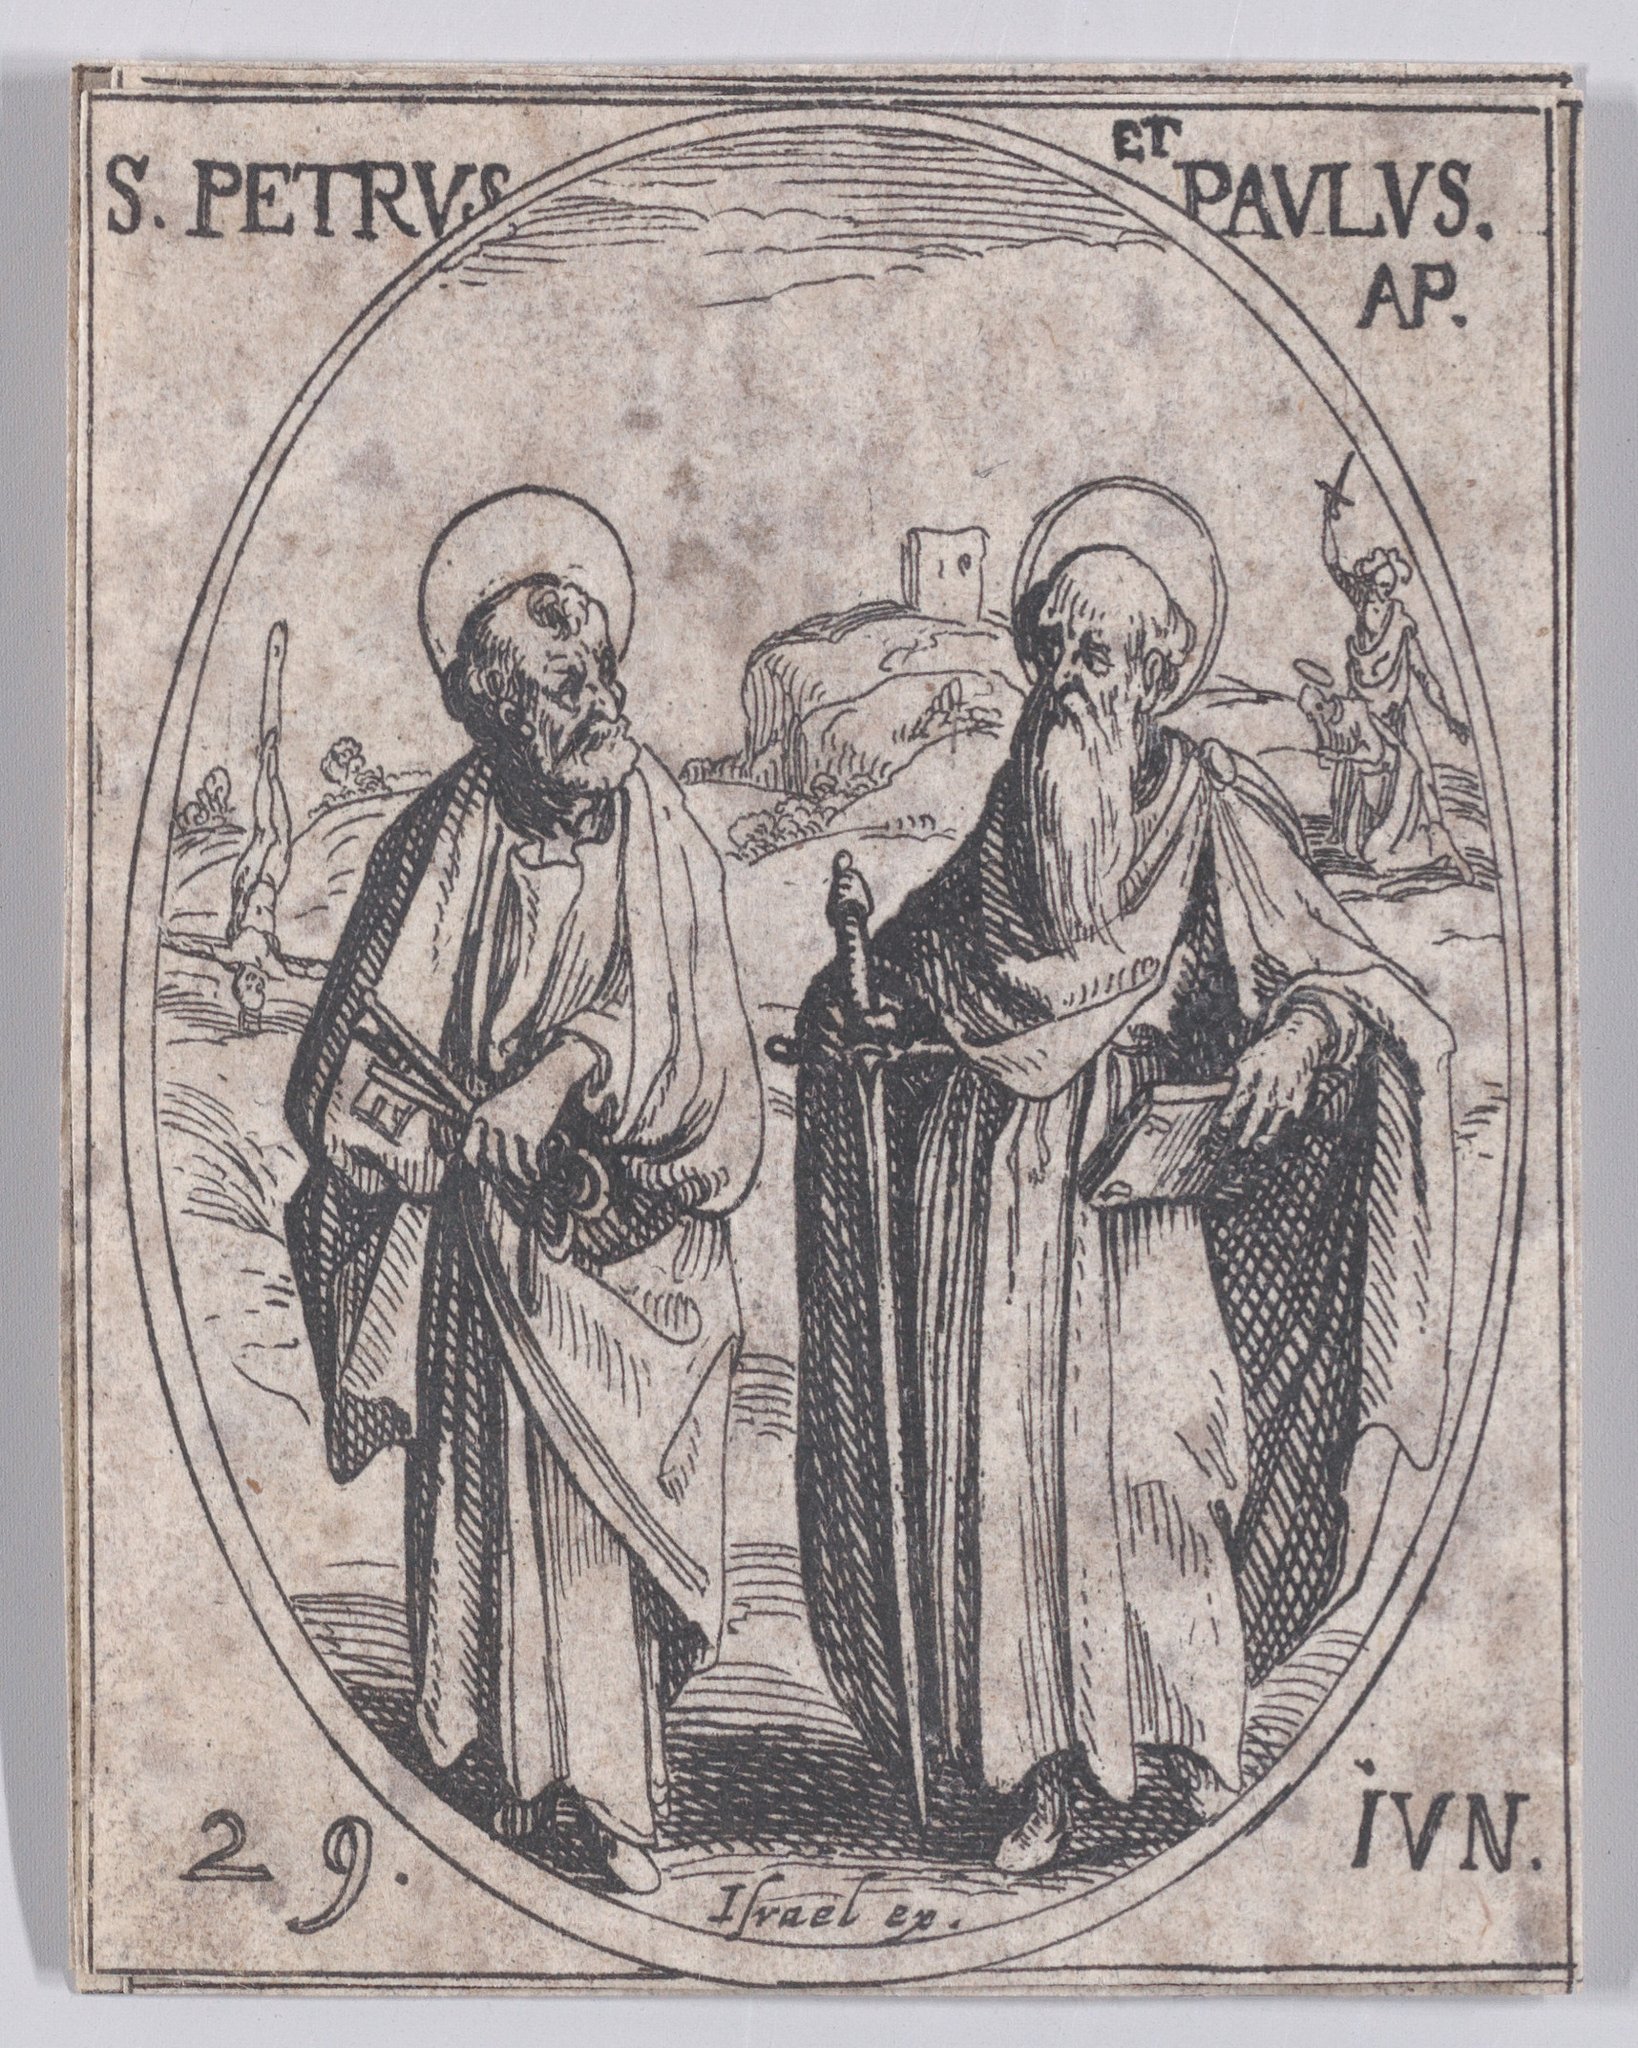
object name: print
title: S. Pierre et S. Paul, apôtres (St. Peter and St. Paul, Apostles), June 29th, from "Les Images De Tous Les Saincts et Saintes de L'Année" (Images of All of the Saints and Religious Events of the Year)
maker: jacques callot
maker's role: artist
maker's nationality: french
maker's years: 1592-1635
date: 1636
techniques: etching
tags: men,saint paul,saint peter